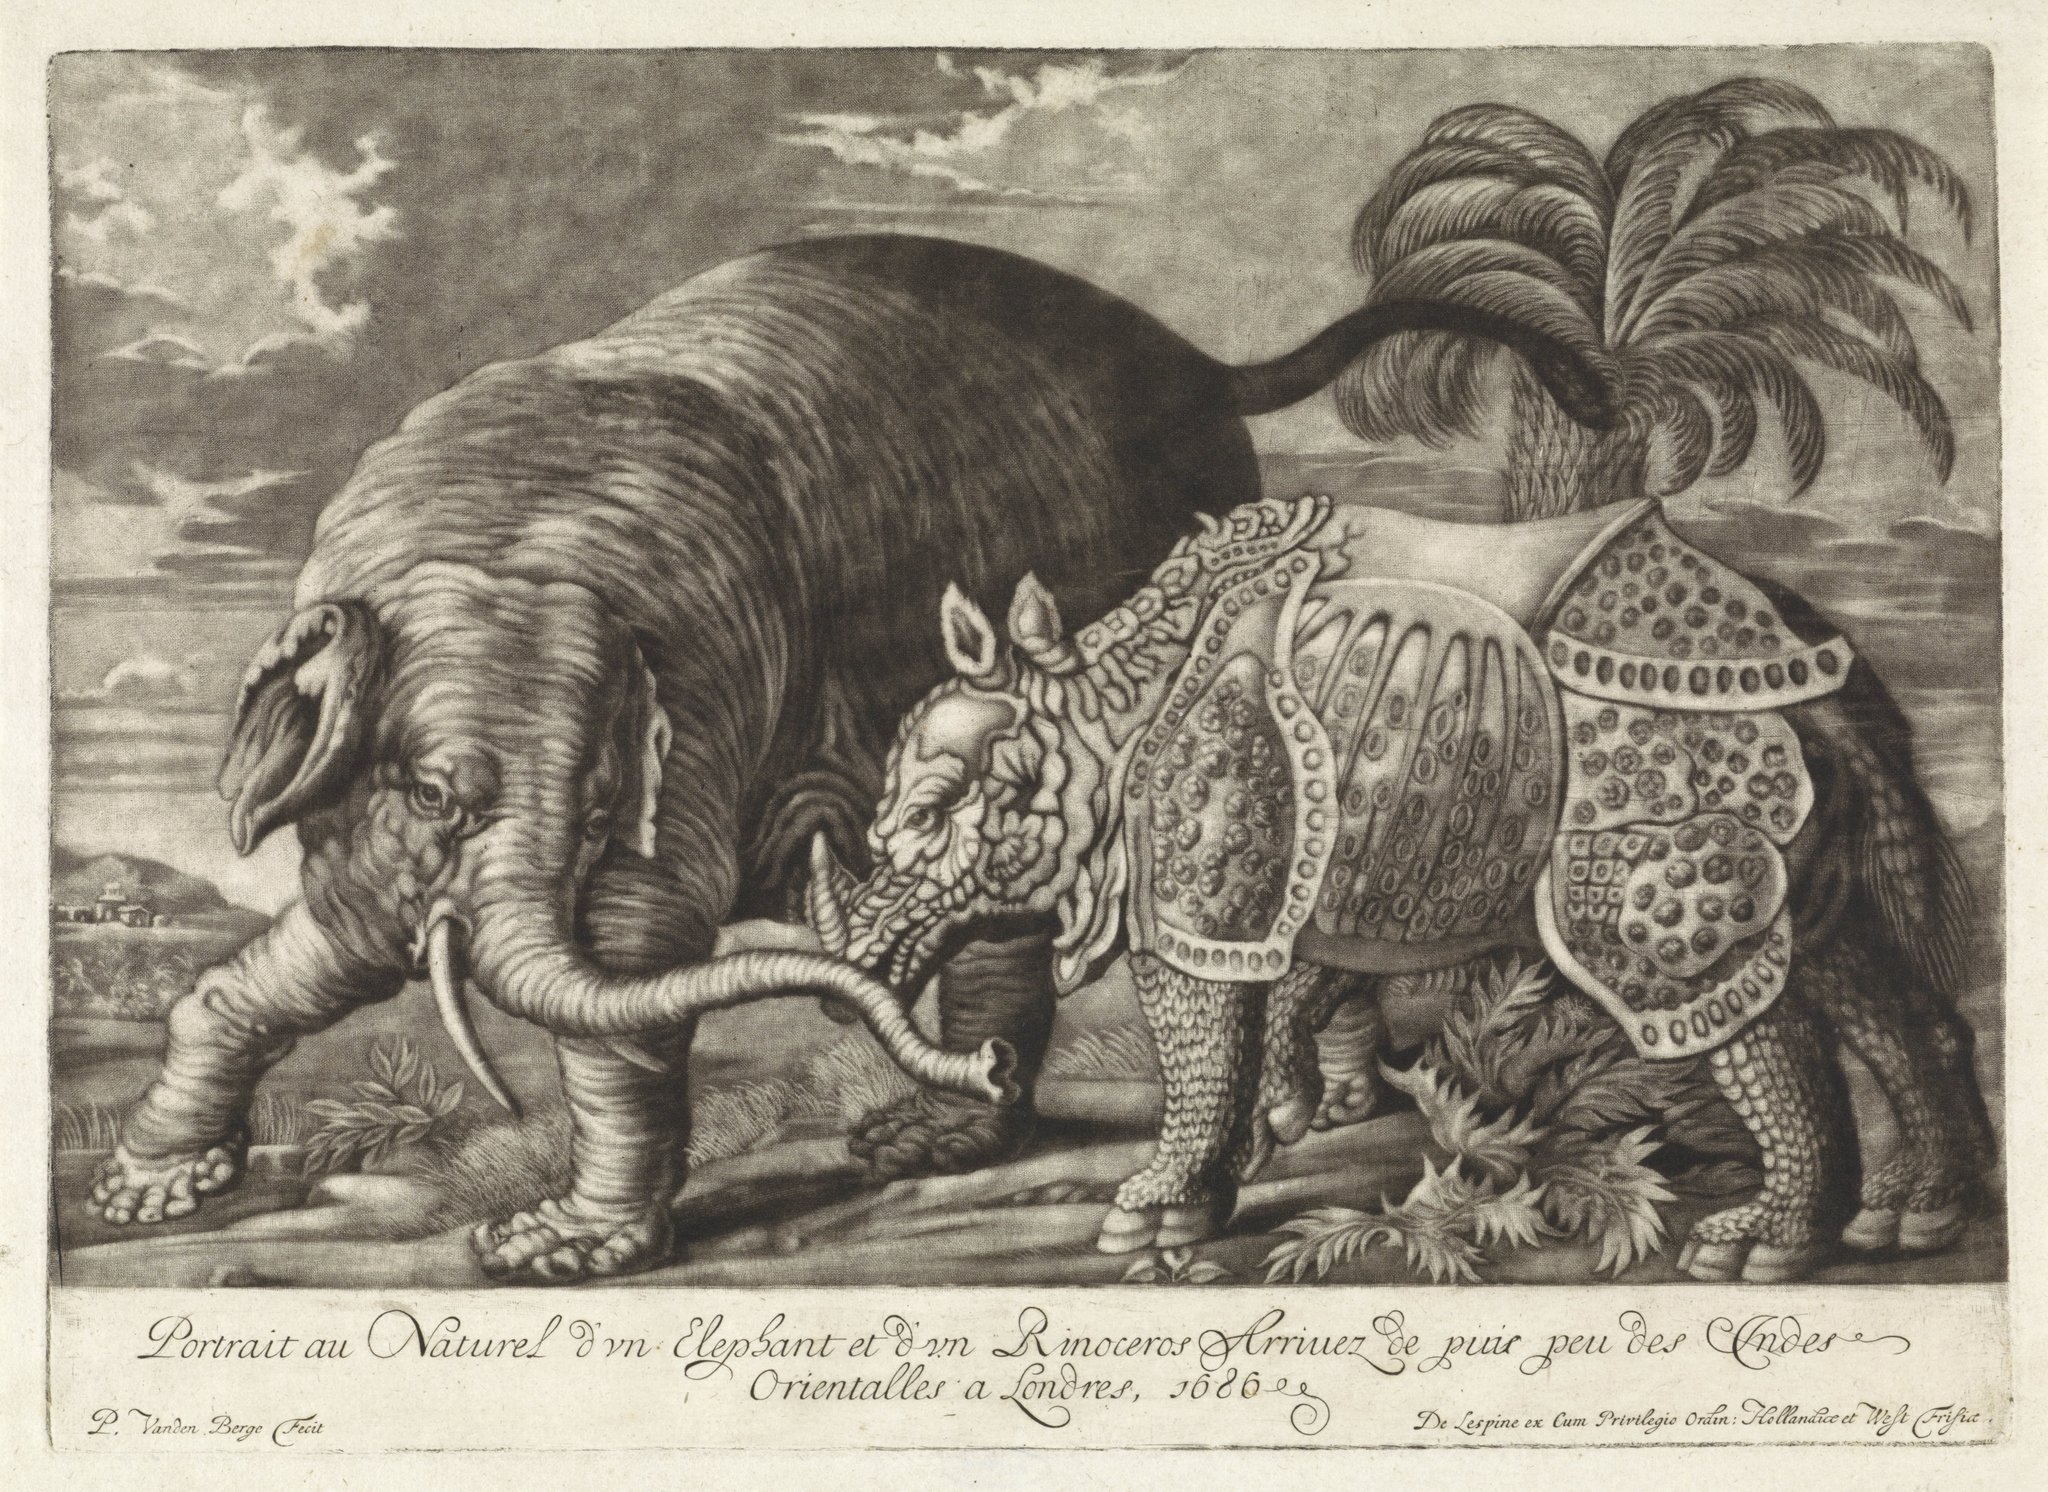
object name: print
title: Elephant and Rhinoceros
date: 1686-1696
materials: paper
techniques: engraving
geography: amsterdam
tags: hoofed animals: rhinoceros, trunked animals: elephant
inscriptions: collector's mark: Lugt 2228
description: A live rhinoceros is first brought ashore in London in 1684. A print depicting a rhino fighting an elephant appears in England, which Pieter van den Berge then republishes in the Netherlands. While the explanatory text states that it is a natural representation of the rhino that arrived in London, the artist actually relies on Dürer’s representation.